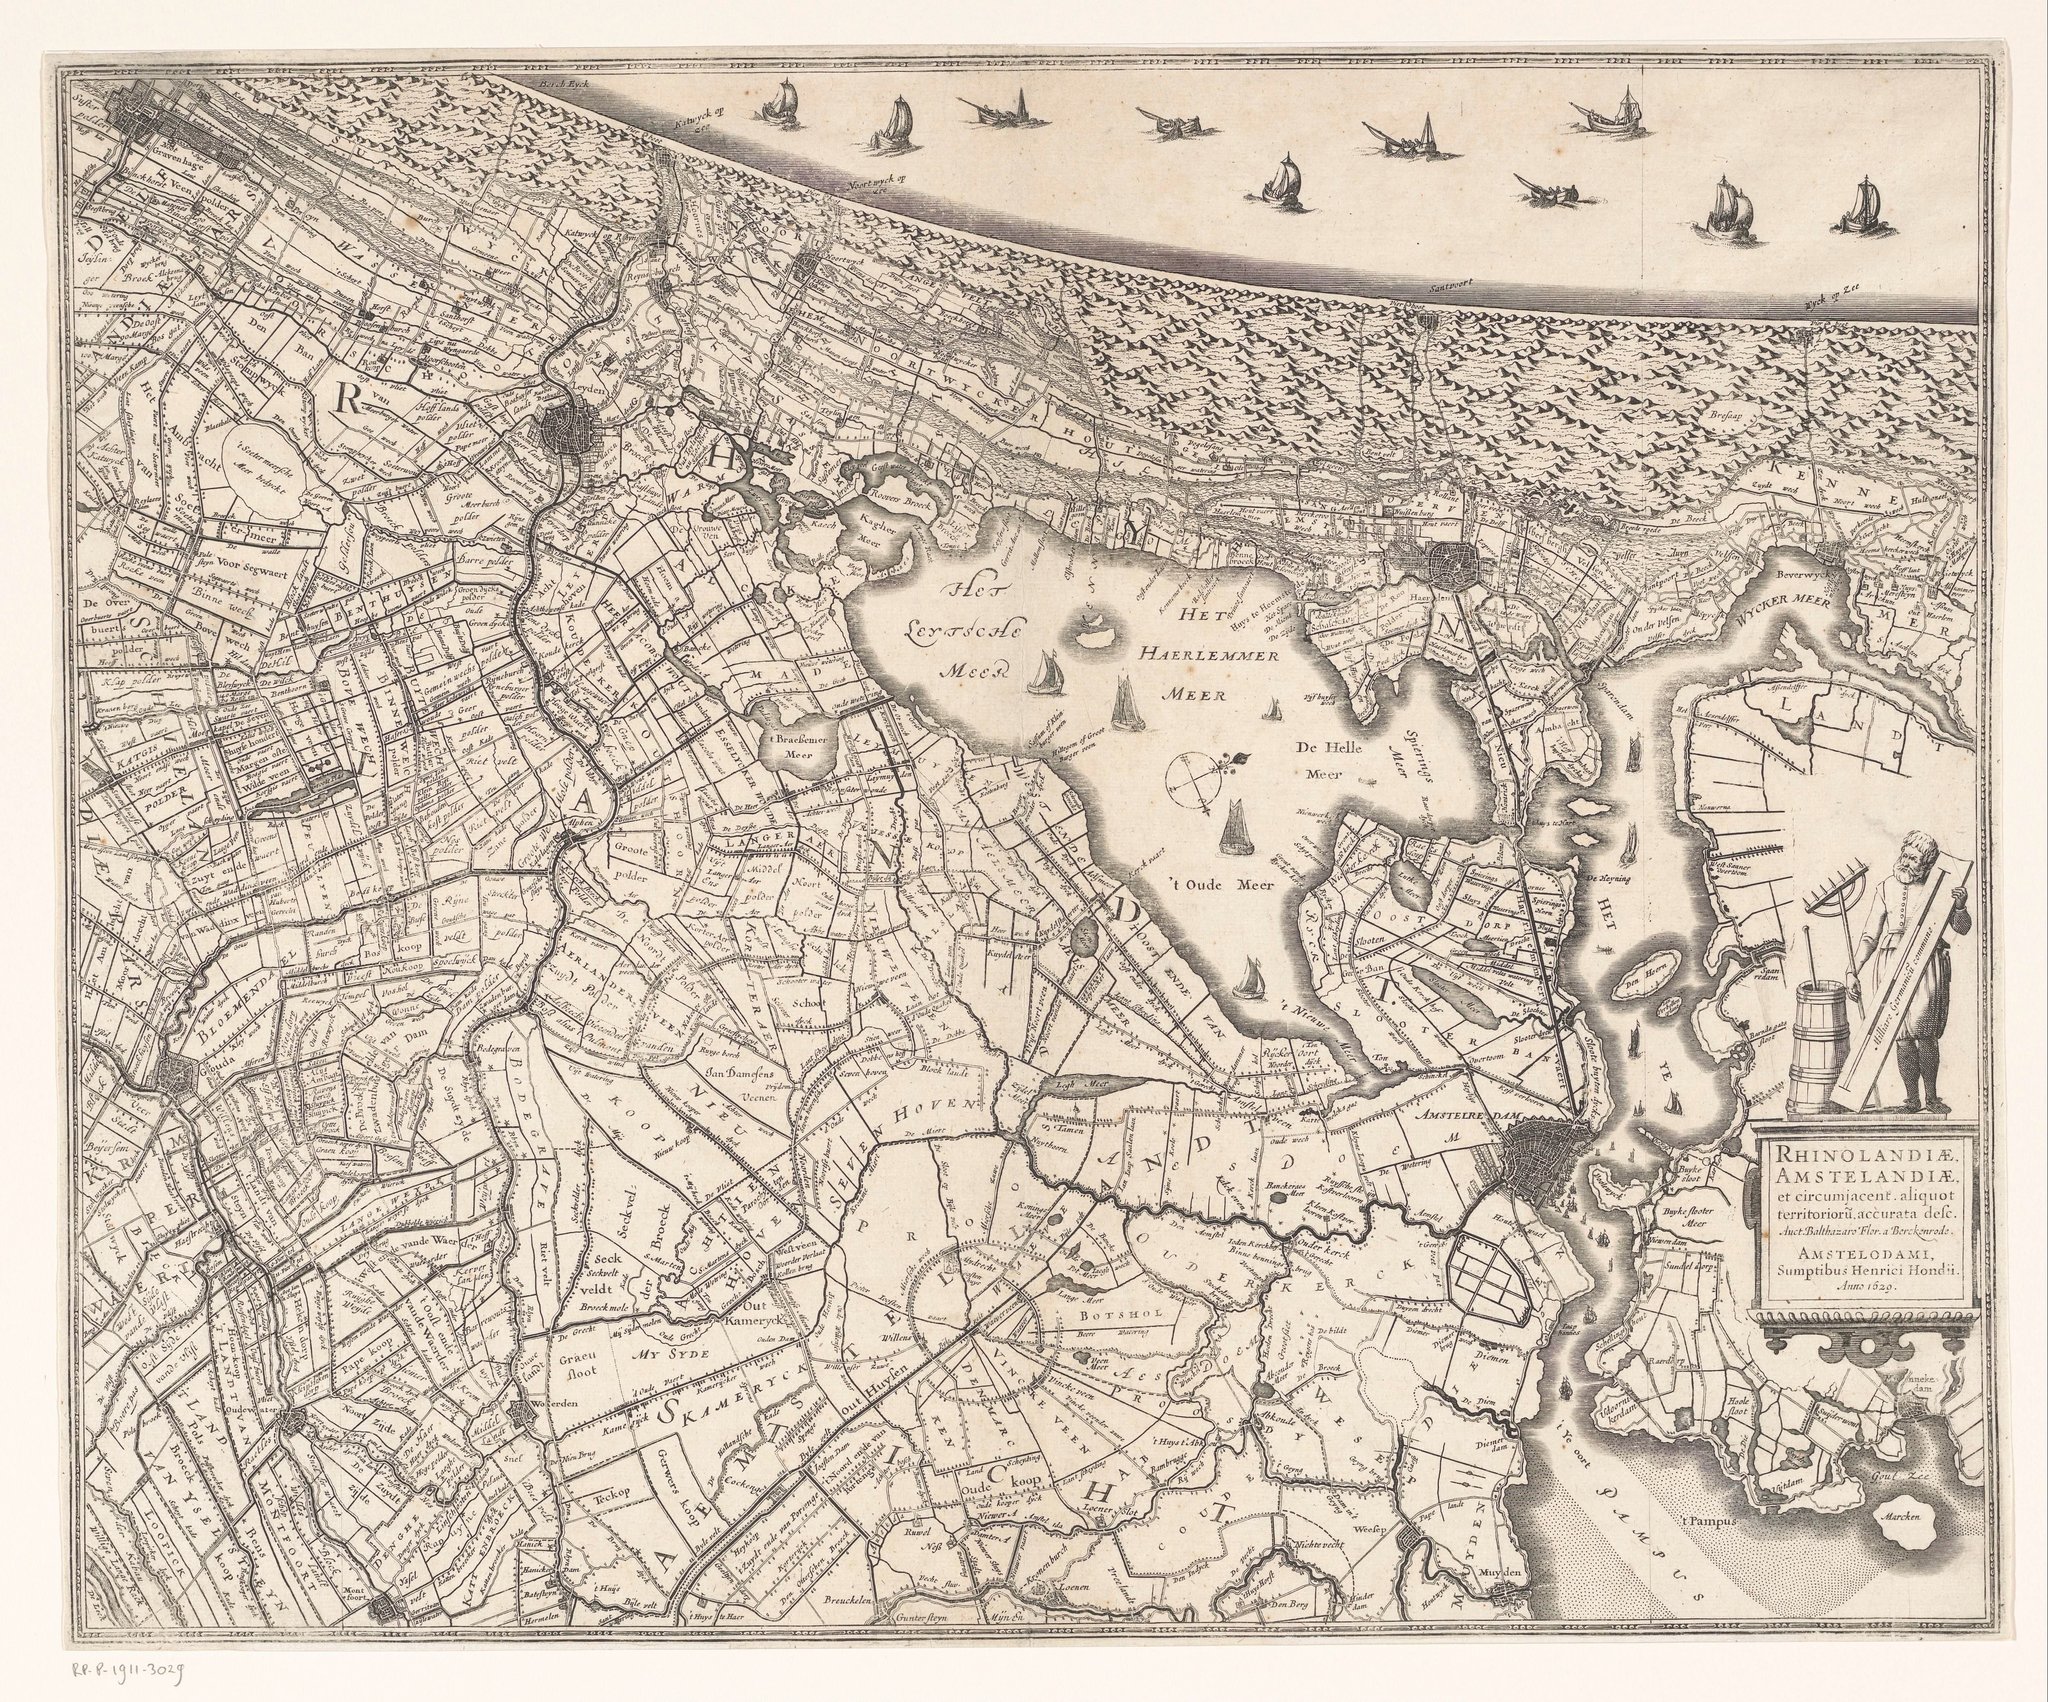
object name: map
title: Kaart van Rijnland en Amstelland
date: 1629-1649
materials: paper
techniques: engraving, etching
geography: amsterdam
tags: maps of separate countries or regions, agricultural implements: rake, rhineland, holland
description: Kaart van Rijnland en Amstelland, het centrale deel van Holland. Rechtsonder de titelcartouche met daarboven een manfiguur met een hark en een schaalstok: Milliare Germanicu commune. Oriëntatie: noorden rechts.